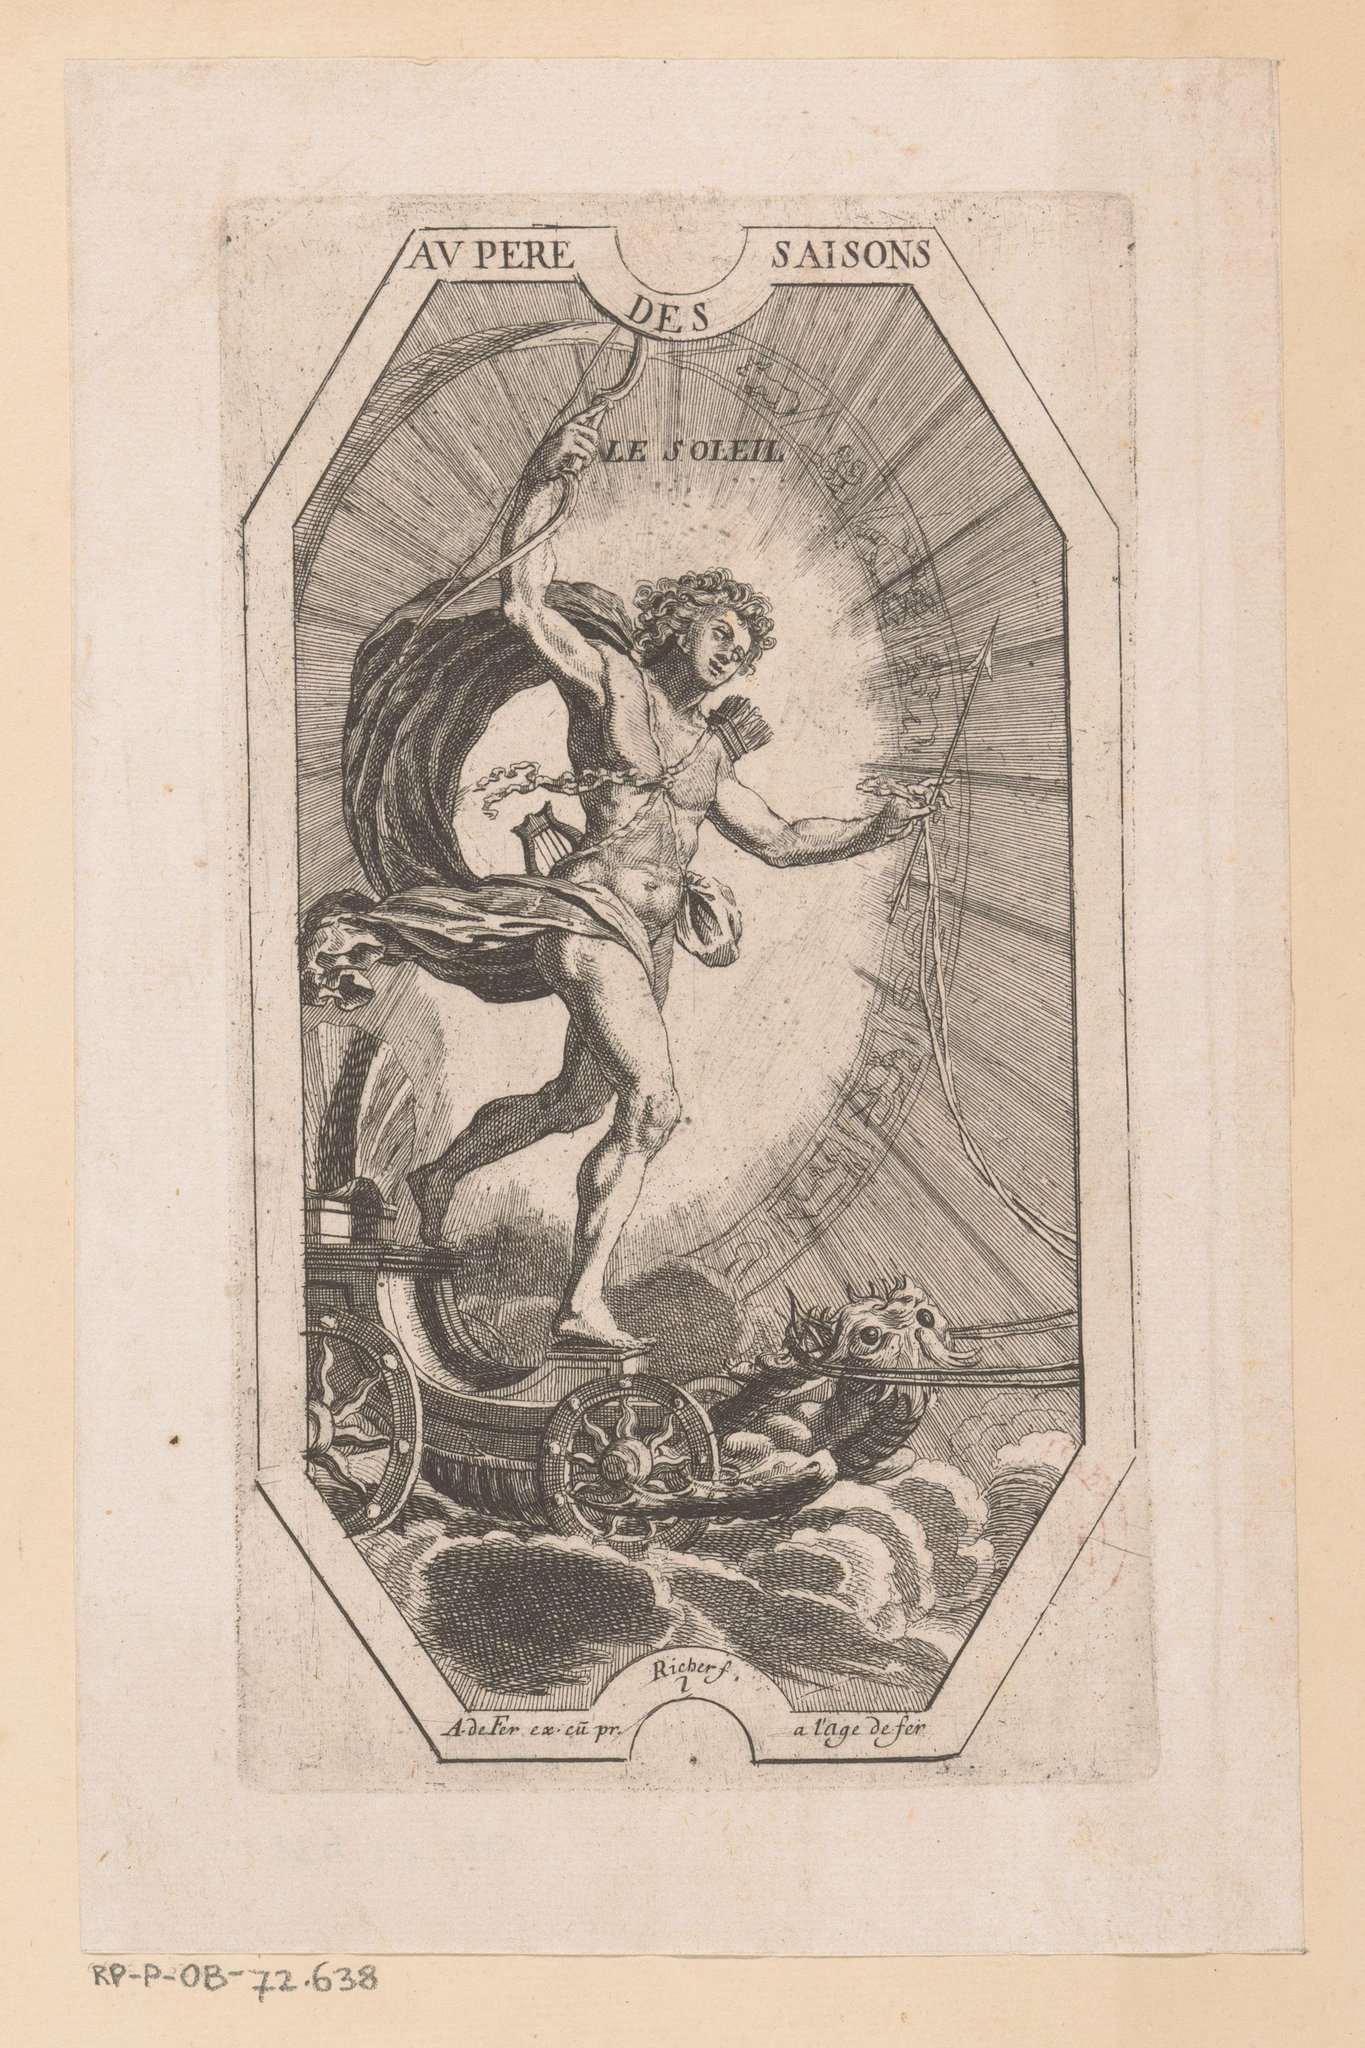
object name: print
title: Apollo als zonnegod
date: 1630-1673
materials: paper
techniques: engraving, etching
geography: paris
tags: apollo as sun-god, i.e. sol (helius), titan, sun as celestial body, planets; planetary system, solar system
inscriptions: collector's mark: Lugt 240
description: Prent maakt deel uit van een serie met in ieder geval zeven genummerde prenten (collectie Rijksmuseum). Dit is nummer 1.